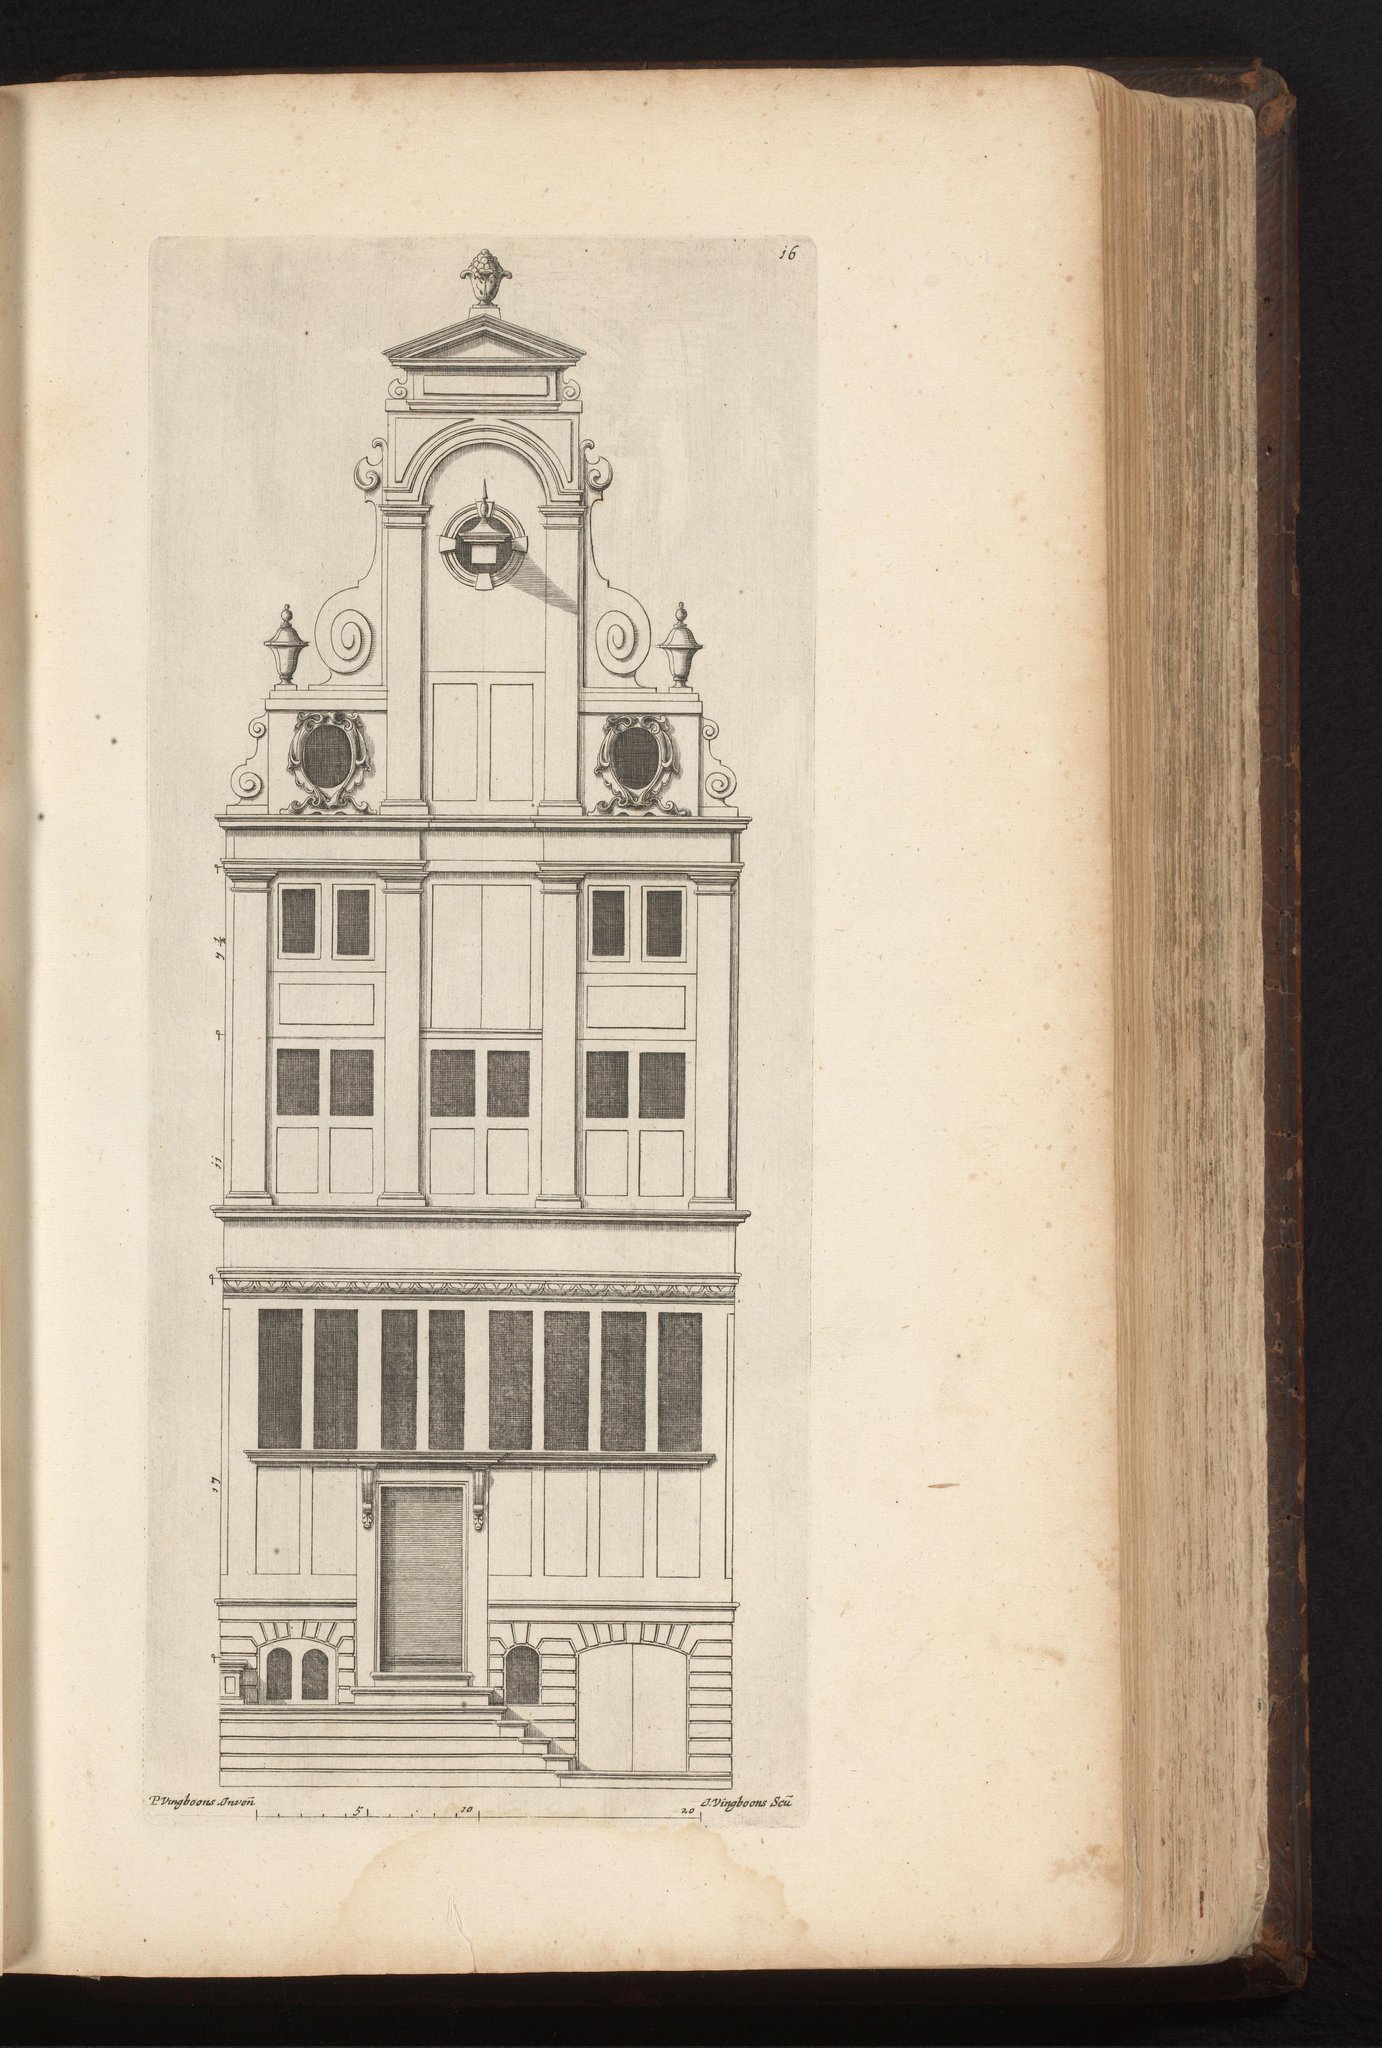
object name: book illustration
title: Gevel van een herenhuis aan het Damrak te Amsterdam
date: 1648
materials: paper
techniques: engraving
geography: amsterdam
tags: urban housing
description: Prent uit: Afbeelsels der voornaemste gebouwen uyt alle die Philips Vingboons geordineert heeft. Amsterdam: Philips en Johannes Vinckboons en Johannes Willemszoon Blaeu, 1648.